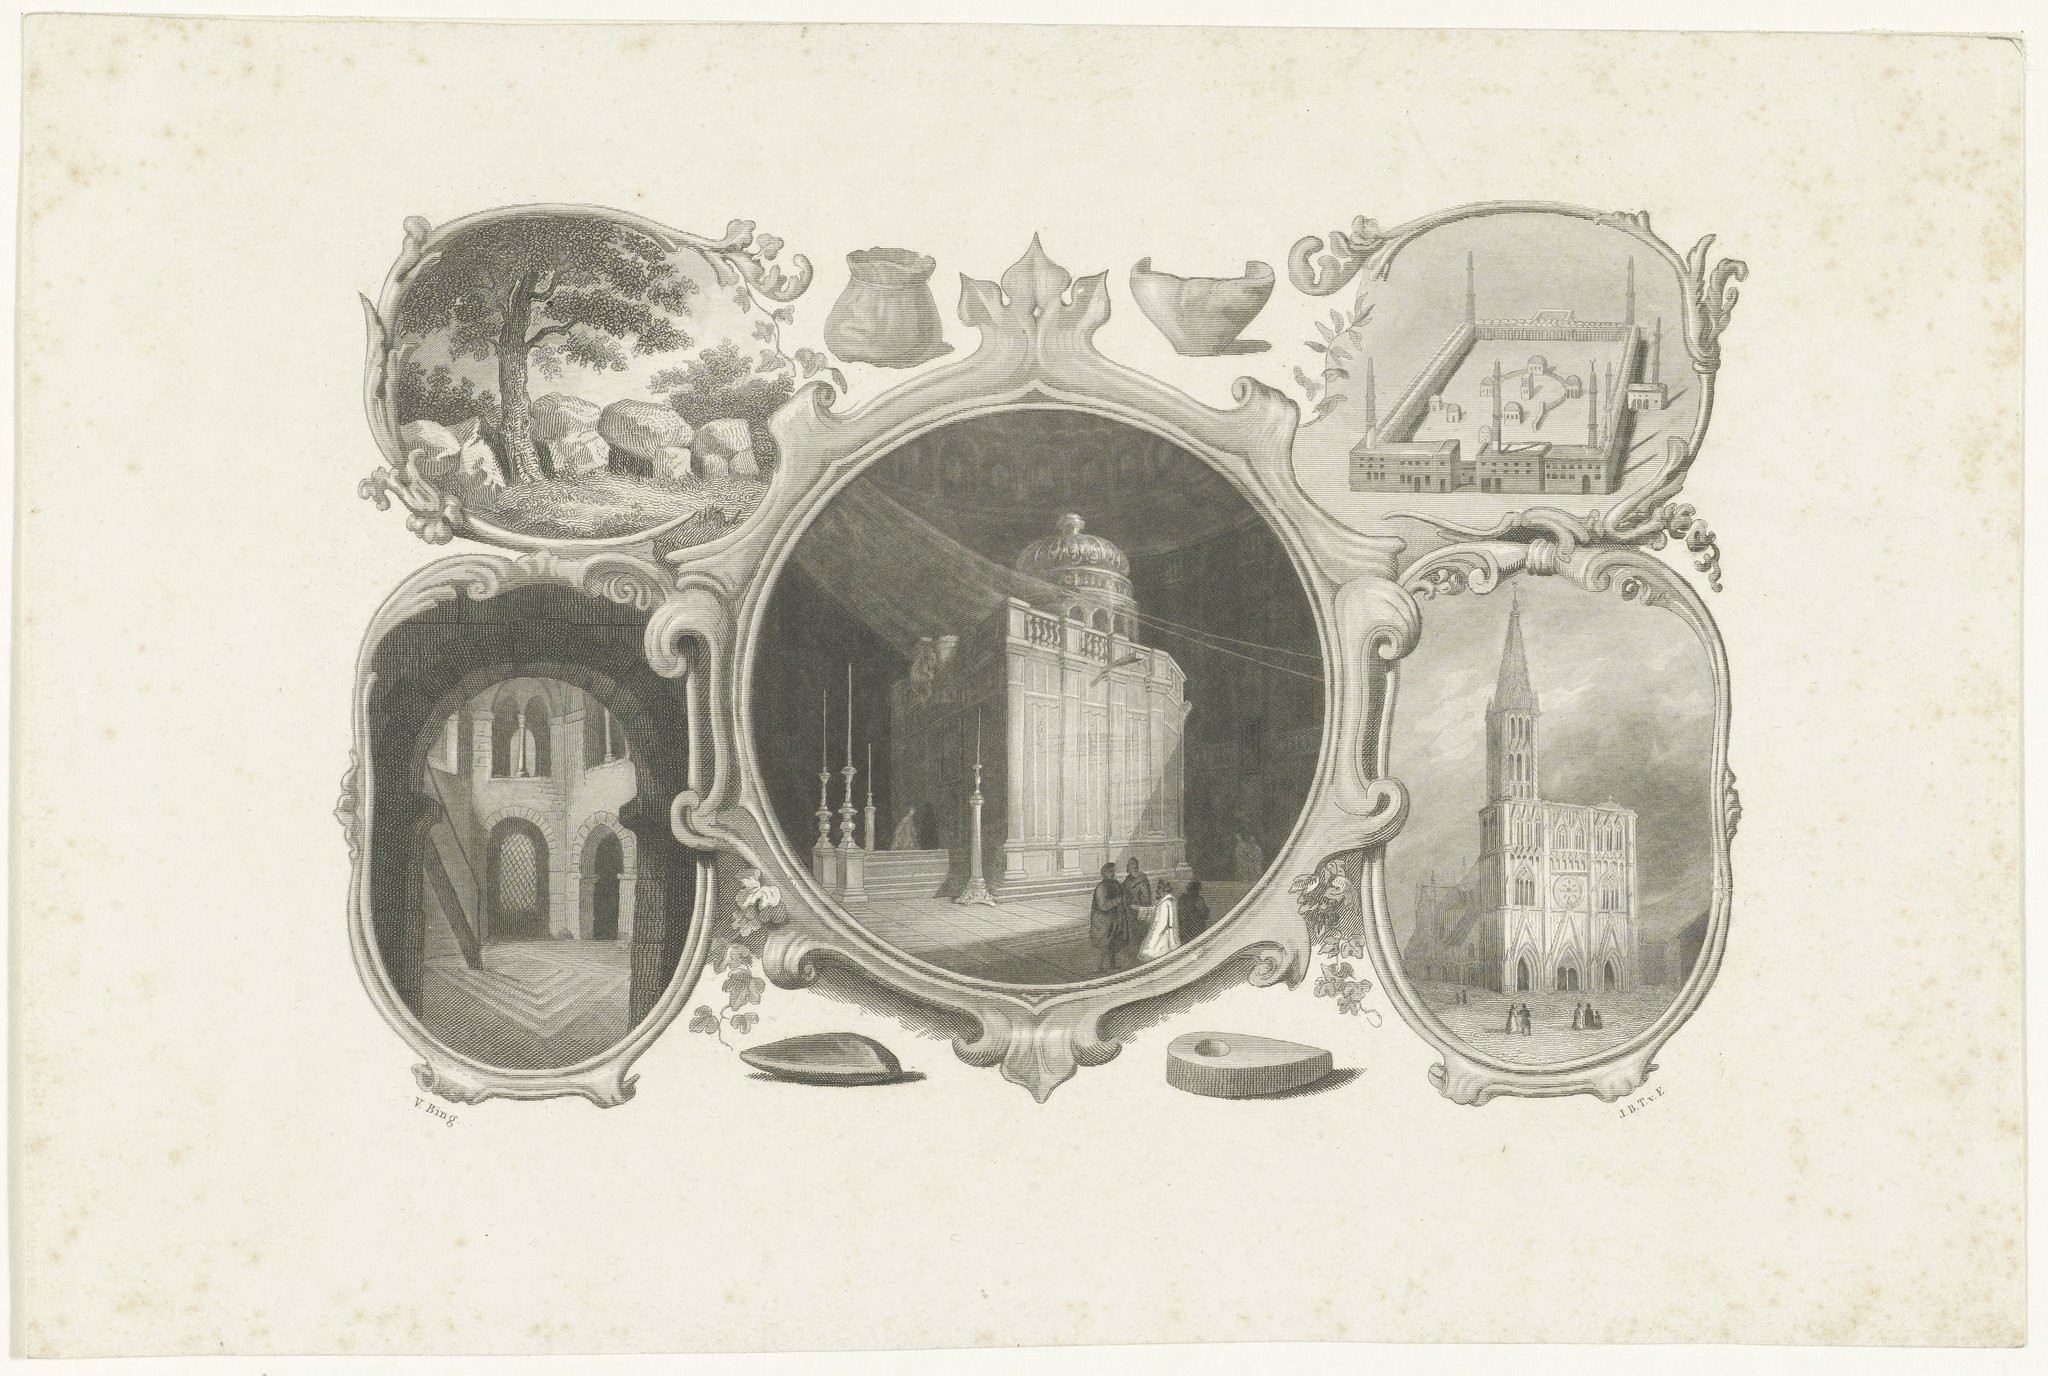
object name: print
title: Graven en heiligdommen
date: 1815-1889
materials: paper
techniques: engraving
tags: grave, tomb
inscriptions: collector's mark: Lugt 2228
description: Een rond cartouche waarin het interieur van een kerk, met rondom nog vier cartouches waarin gezichten op graven, een moskeen en een kathedraal.